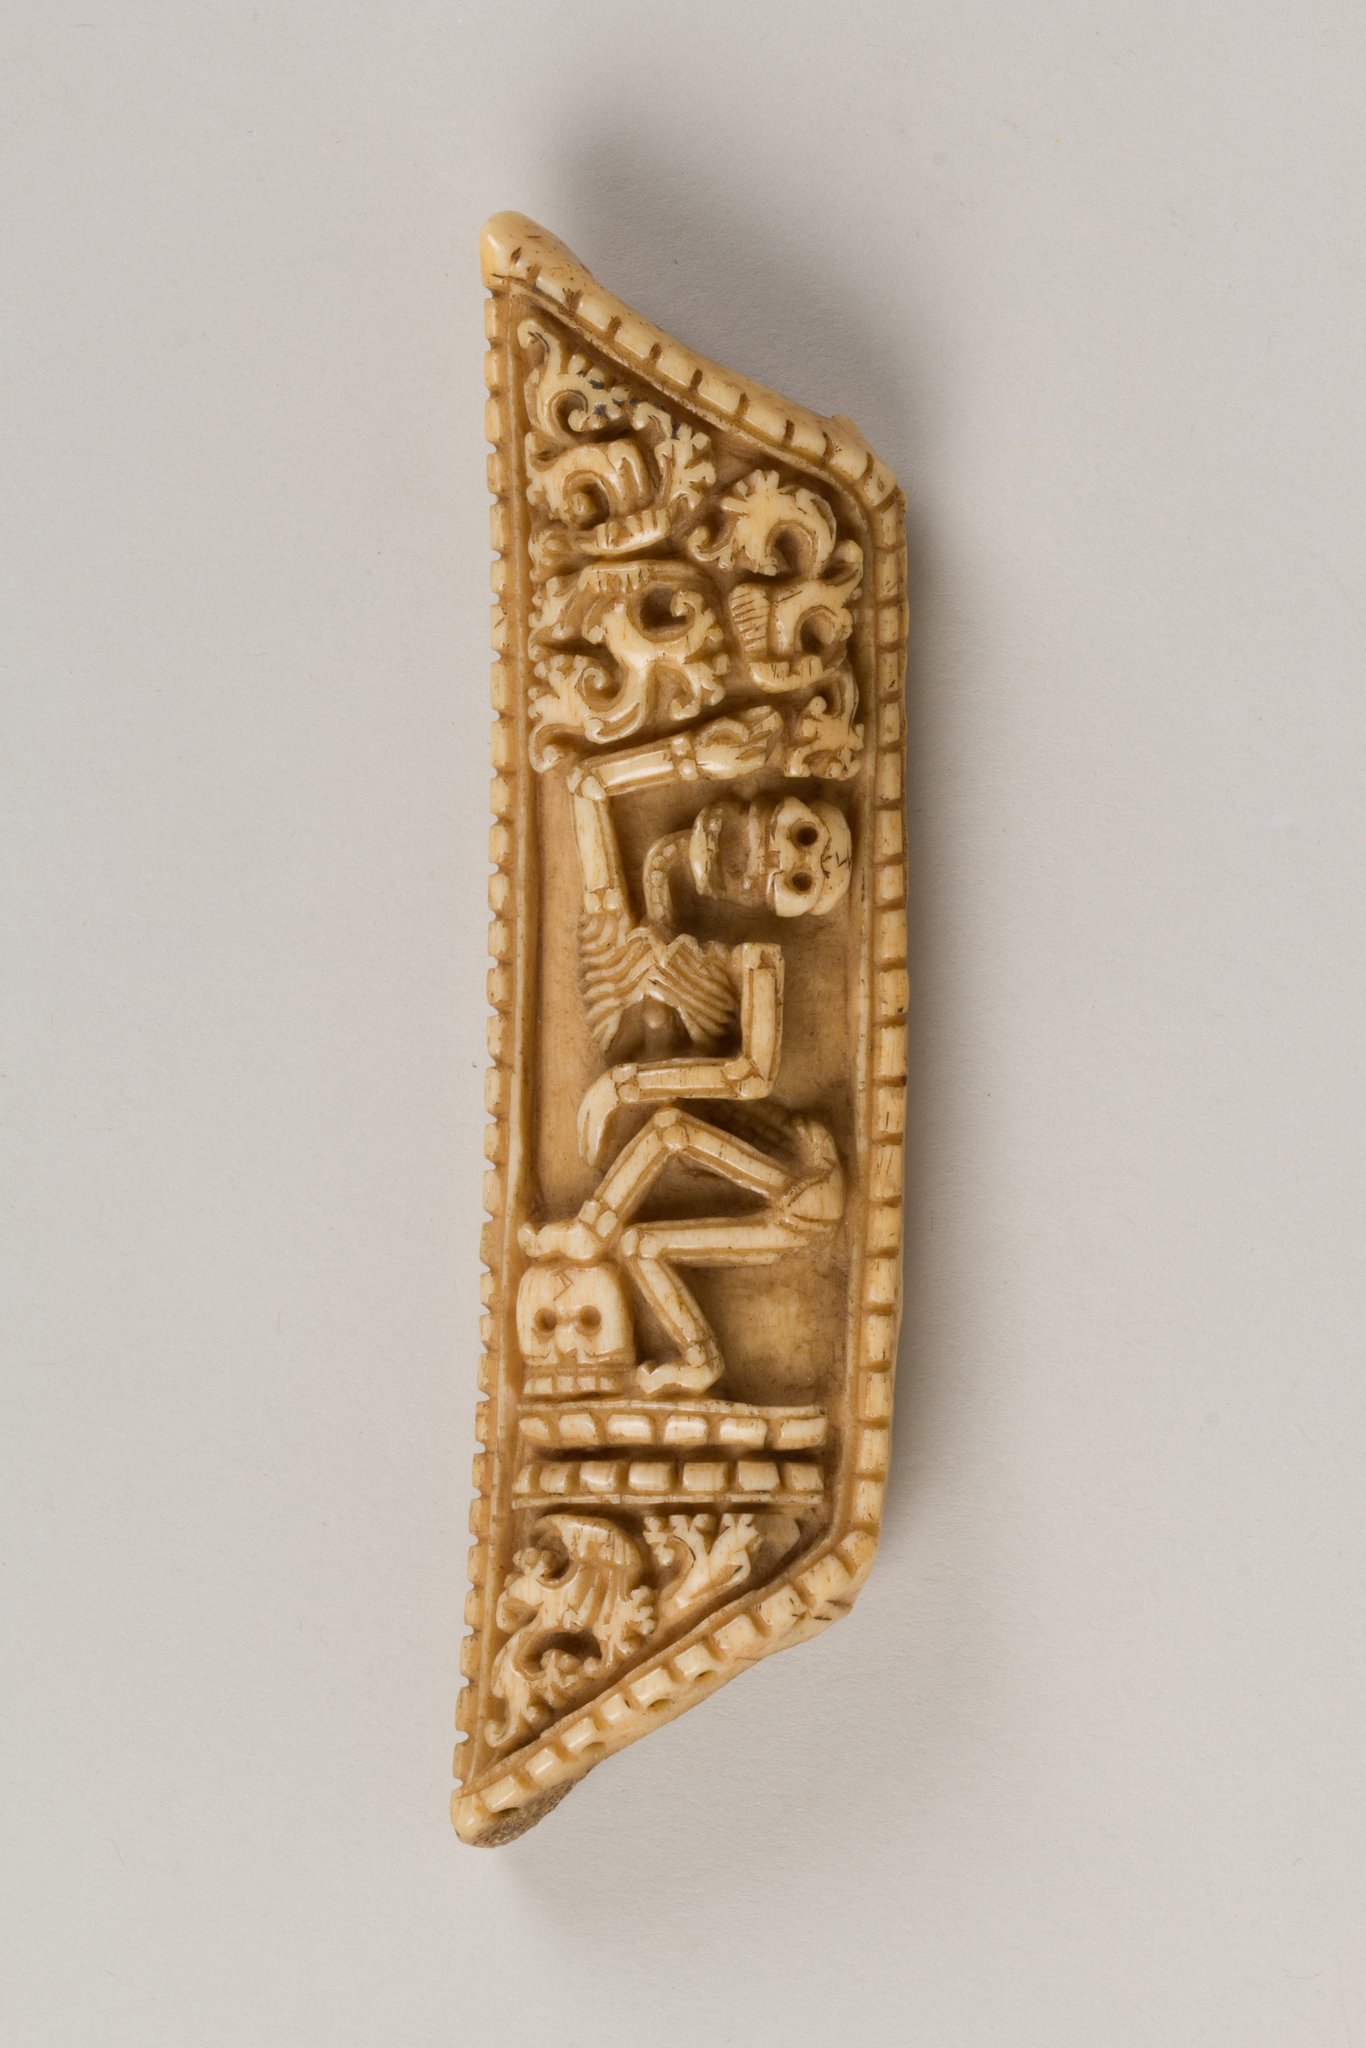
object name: plaque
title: Plaque from a Tantric Ritual Apron with a Skeleton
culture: tibetan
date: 1501-1600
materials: bone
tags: skeletons